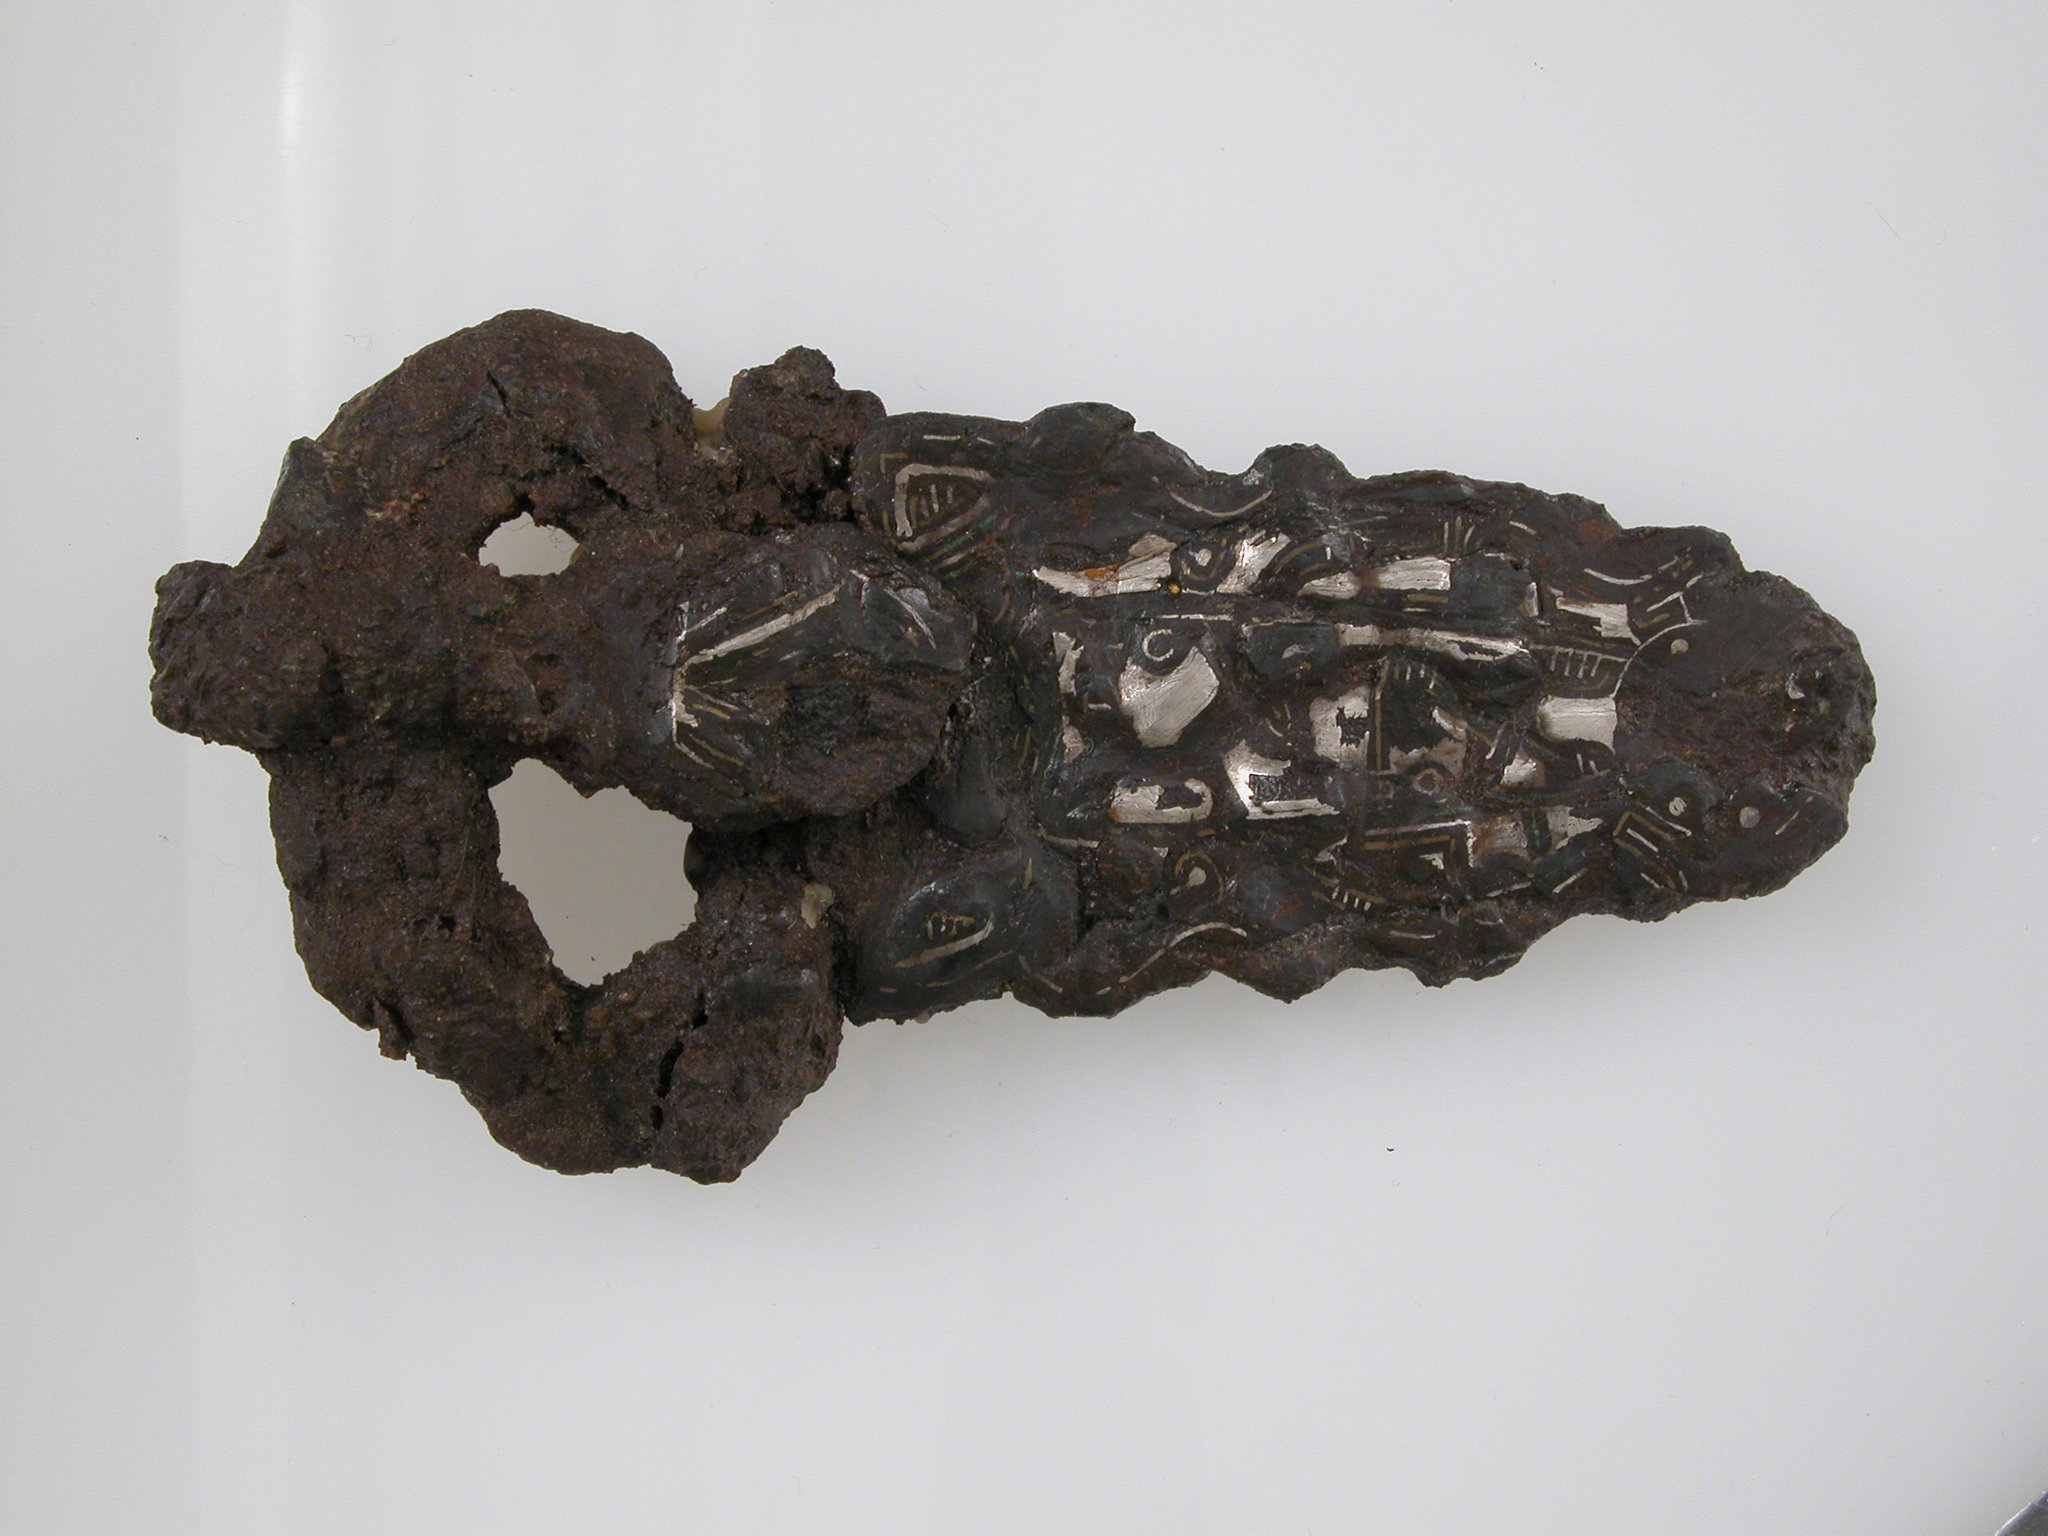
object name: belt buckle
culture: frankish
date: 601-700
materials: iron, silver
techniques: inlay